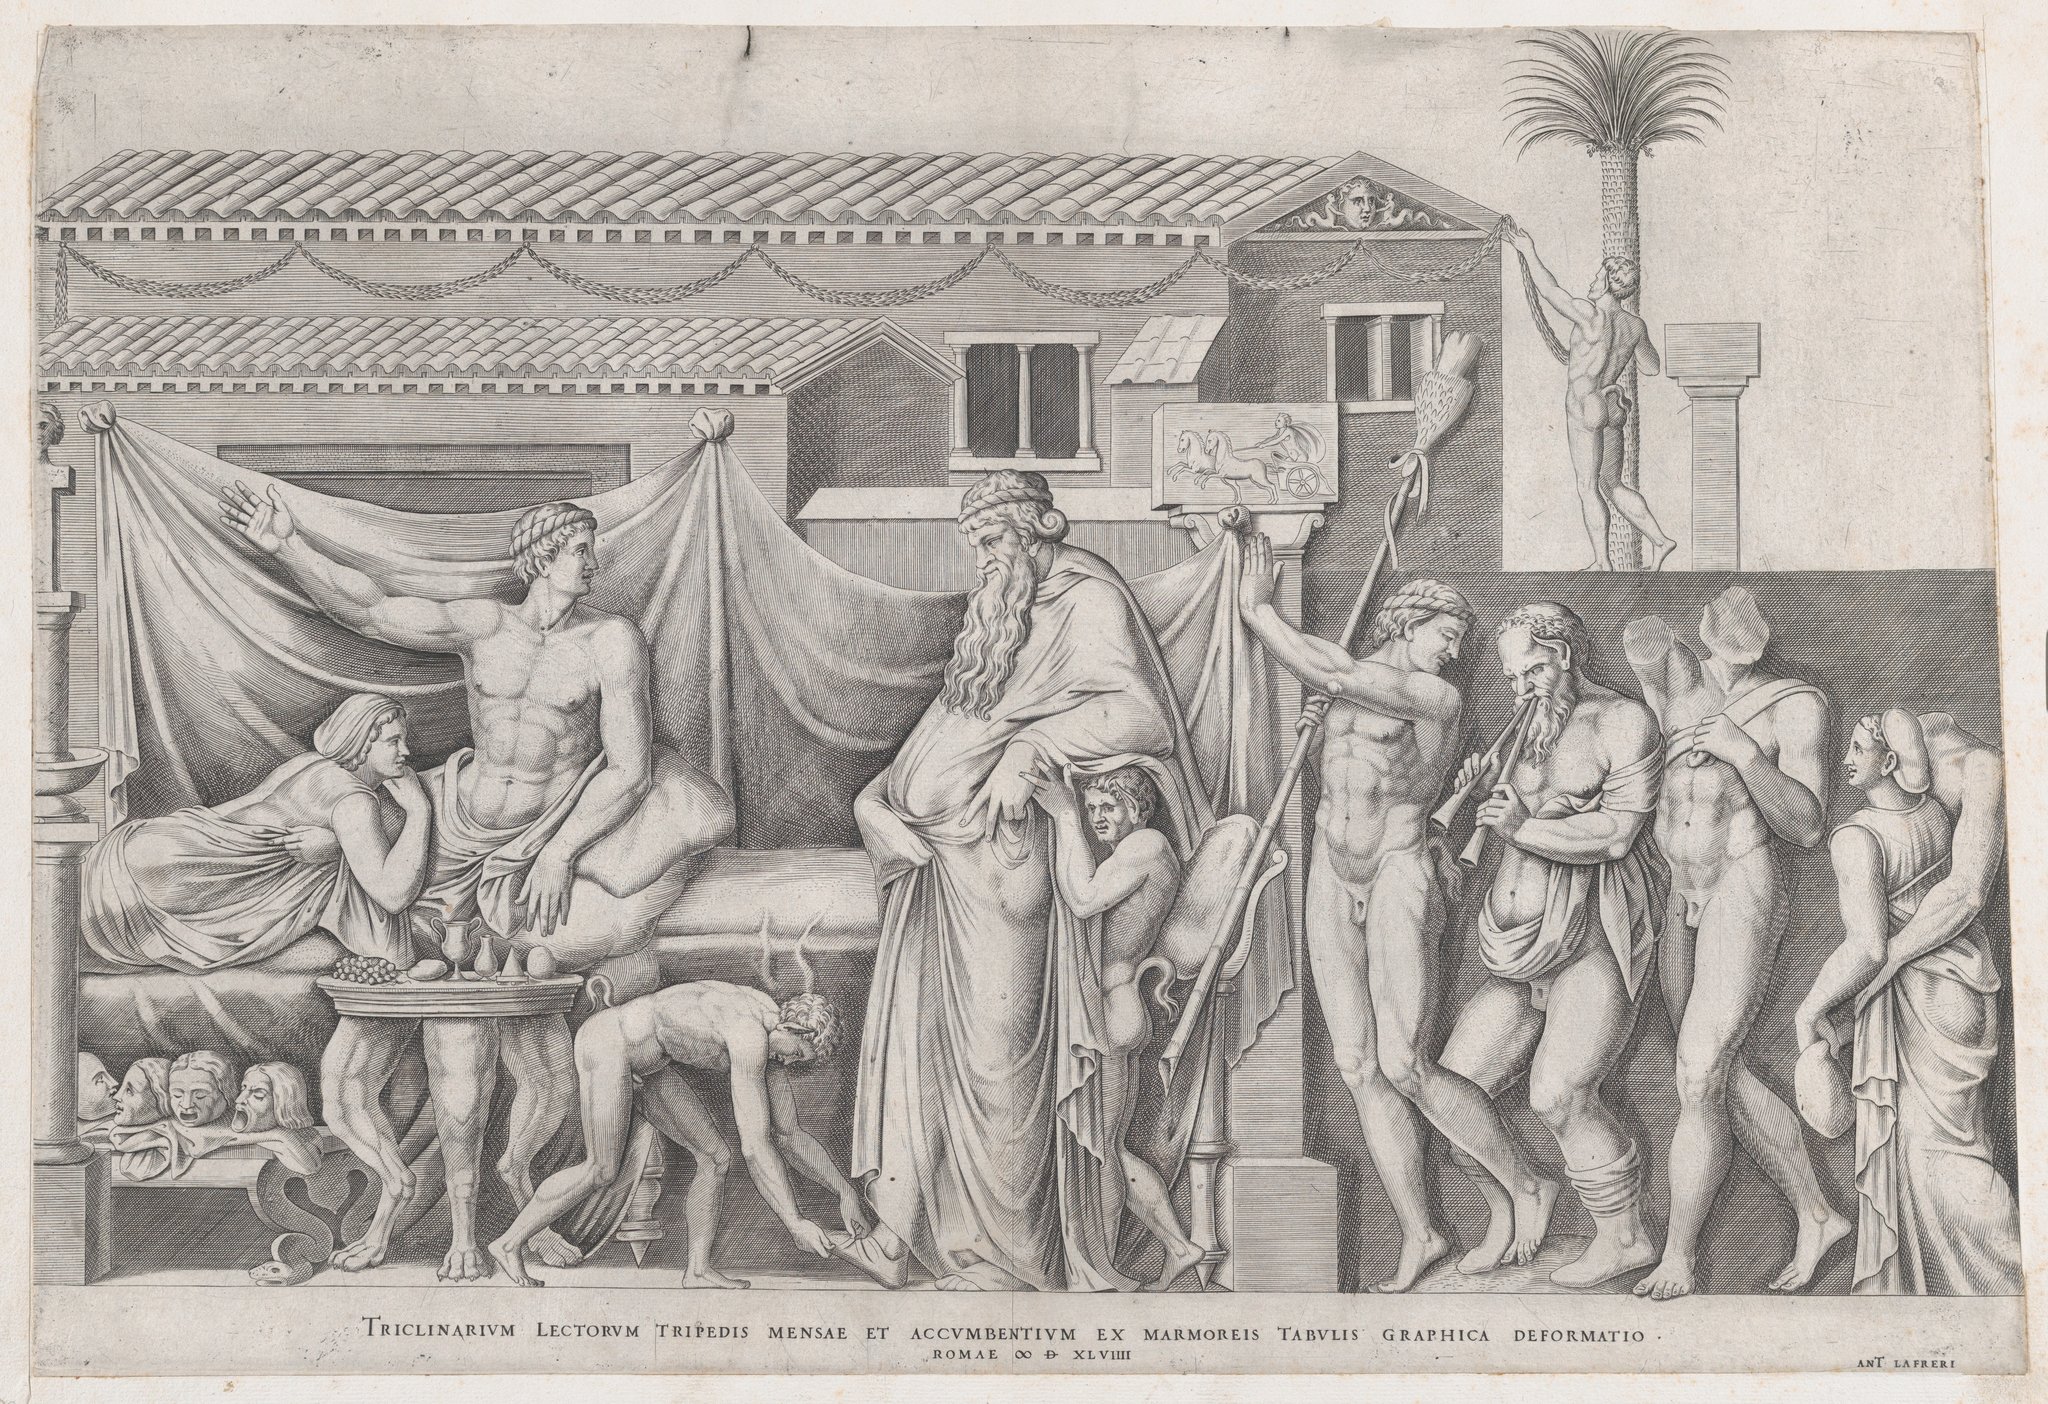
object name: print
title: Festival of Dionysius, from "Speculum Romanae Magnificentiae"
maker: Anonymous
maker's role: artist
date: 1549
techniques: engraving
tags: men,women,dionysus